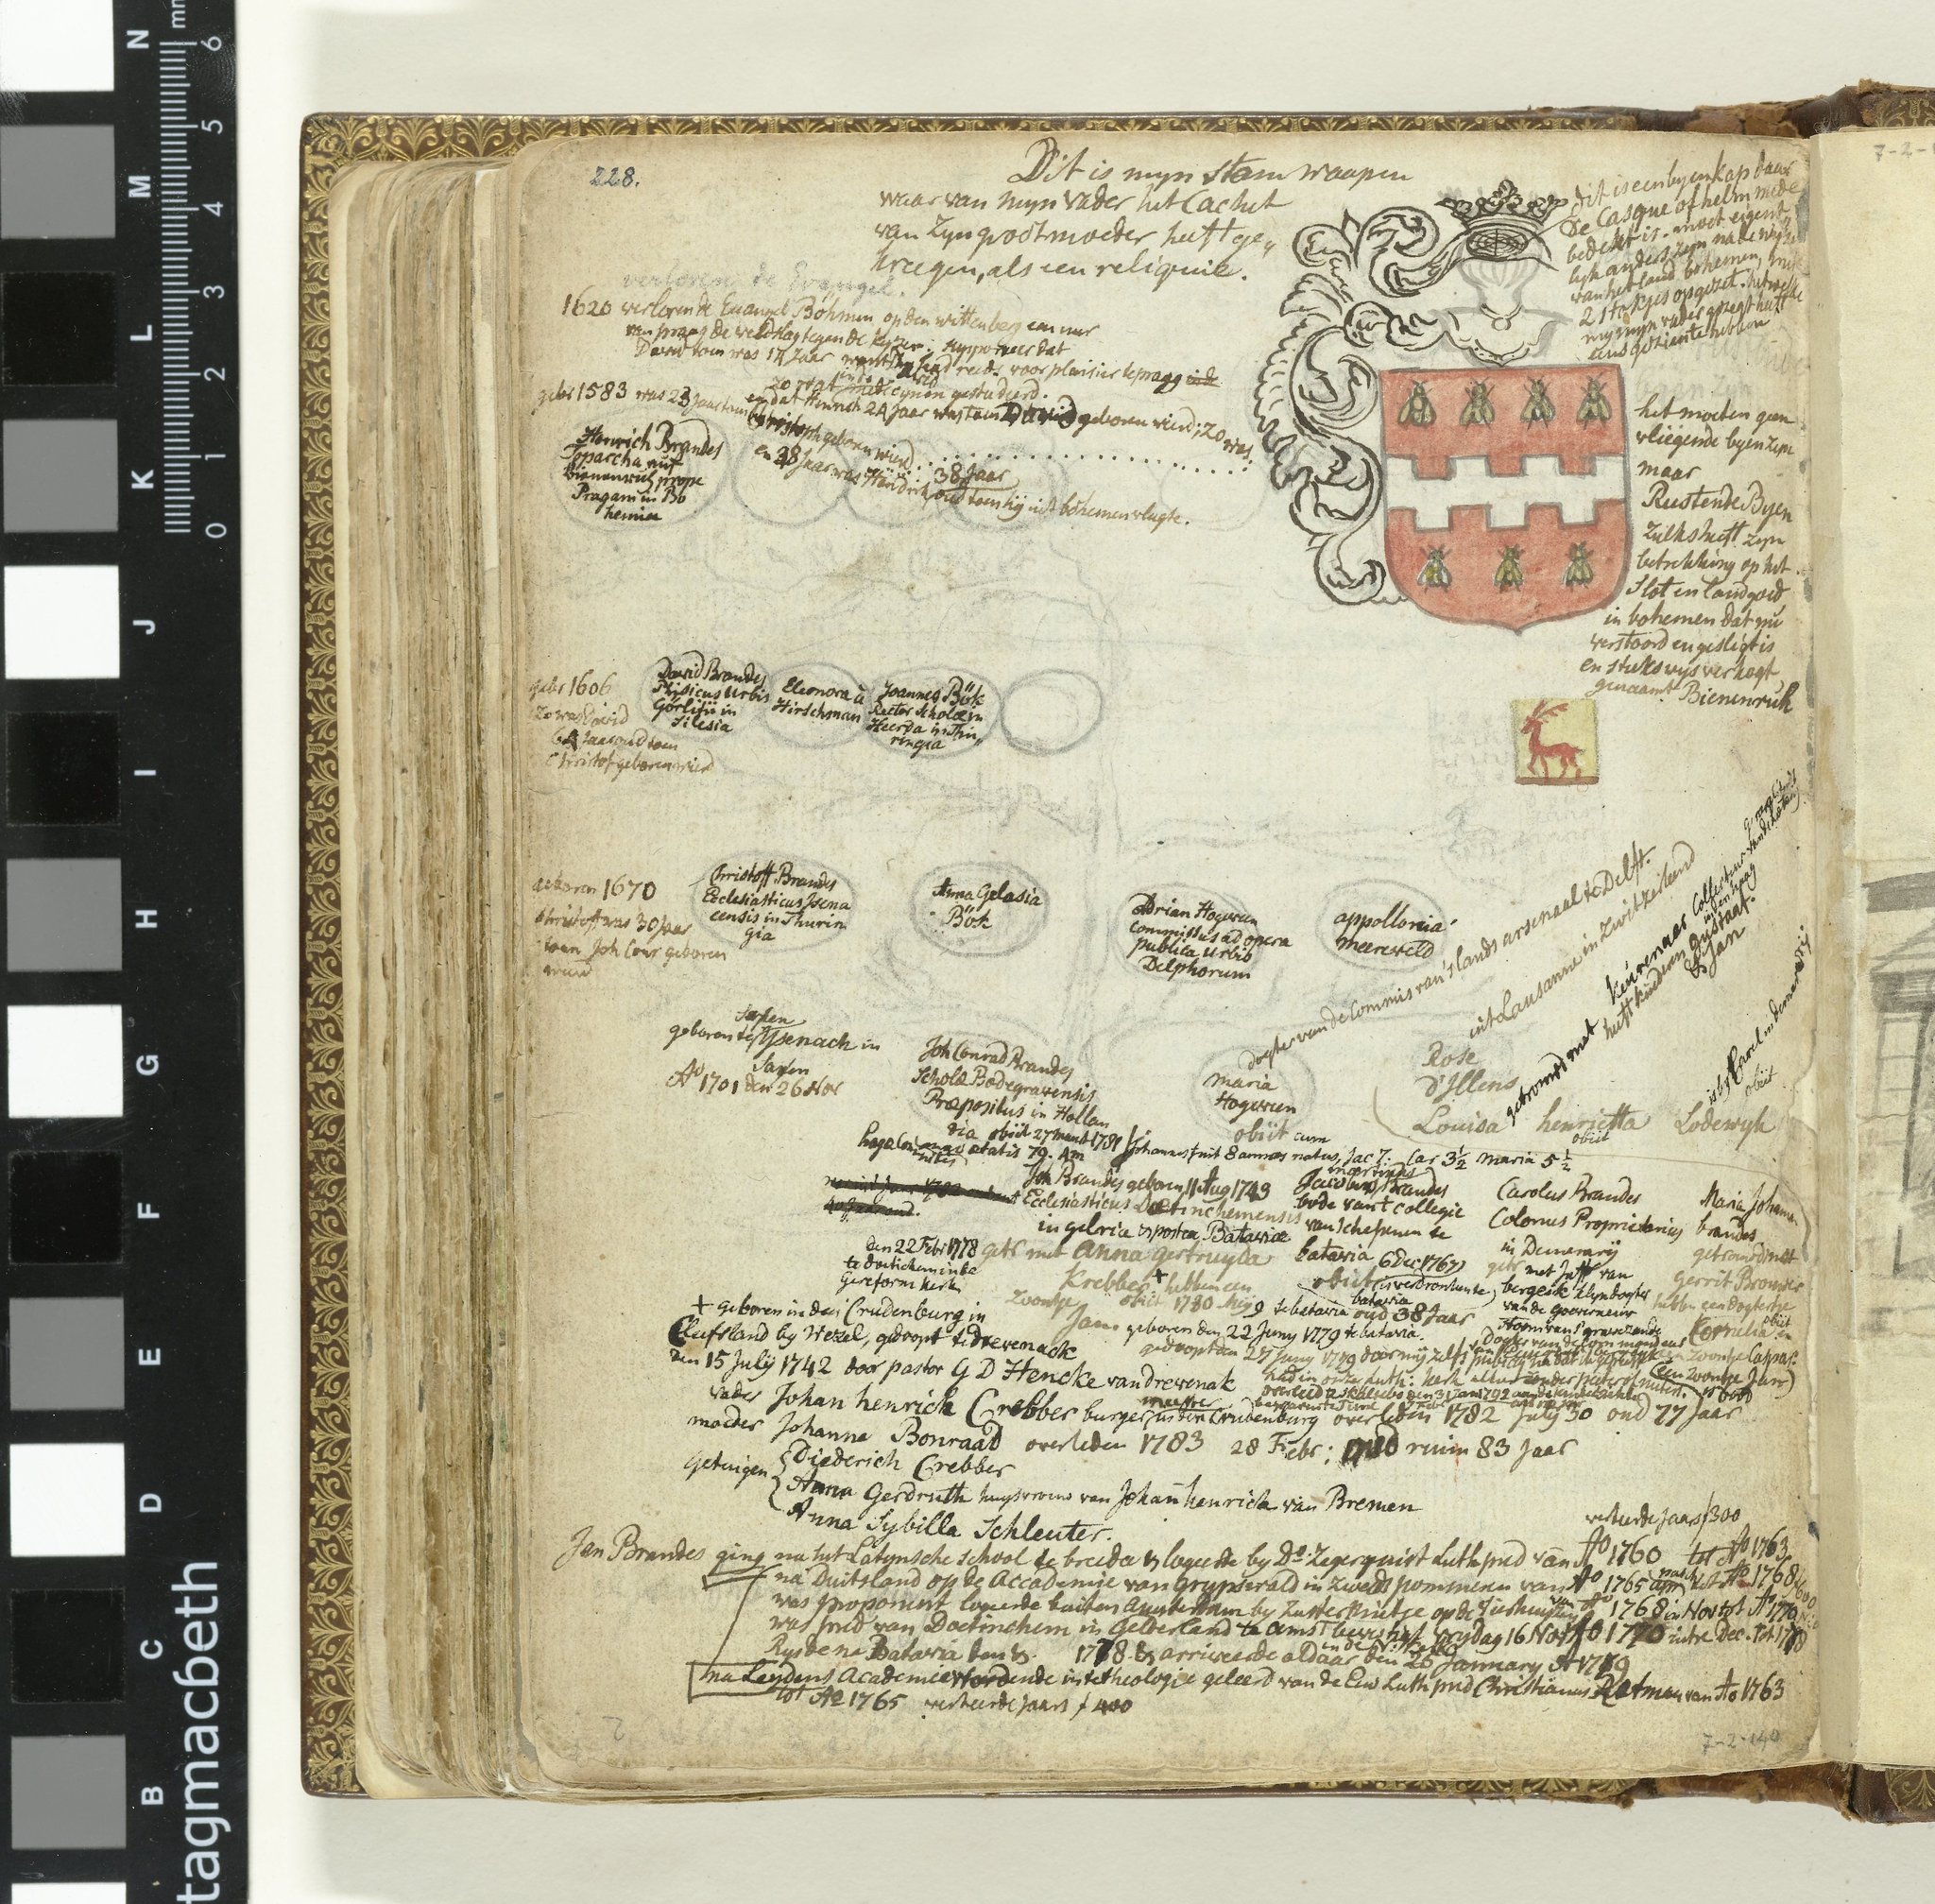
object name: drawing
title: Stamboom en wapen Brandes-familie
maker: jan brandes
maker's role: draughtsman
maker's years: 1743-1808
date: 1778-1792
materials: paper, pencil, watercolor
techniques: brush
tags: bodegraven, jan brandes, armorial bearing, heraldry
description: Kleurtekening van het wapen van familie Brandes. Stamboom van Brandes, 9 pagina's. Met opschrift. Onderdeel uit het schetsboek van Jan Brandes, dl. 2 (1808), p. 228, 230-237.